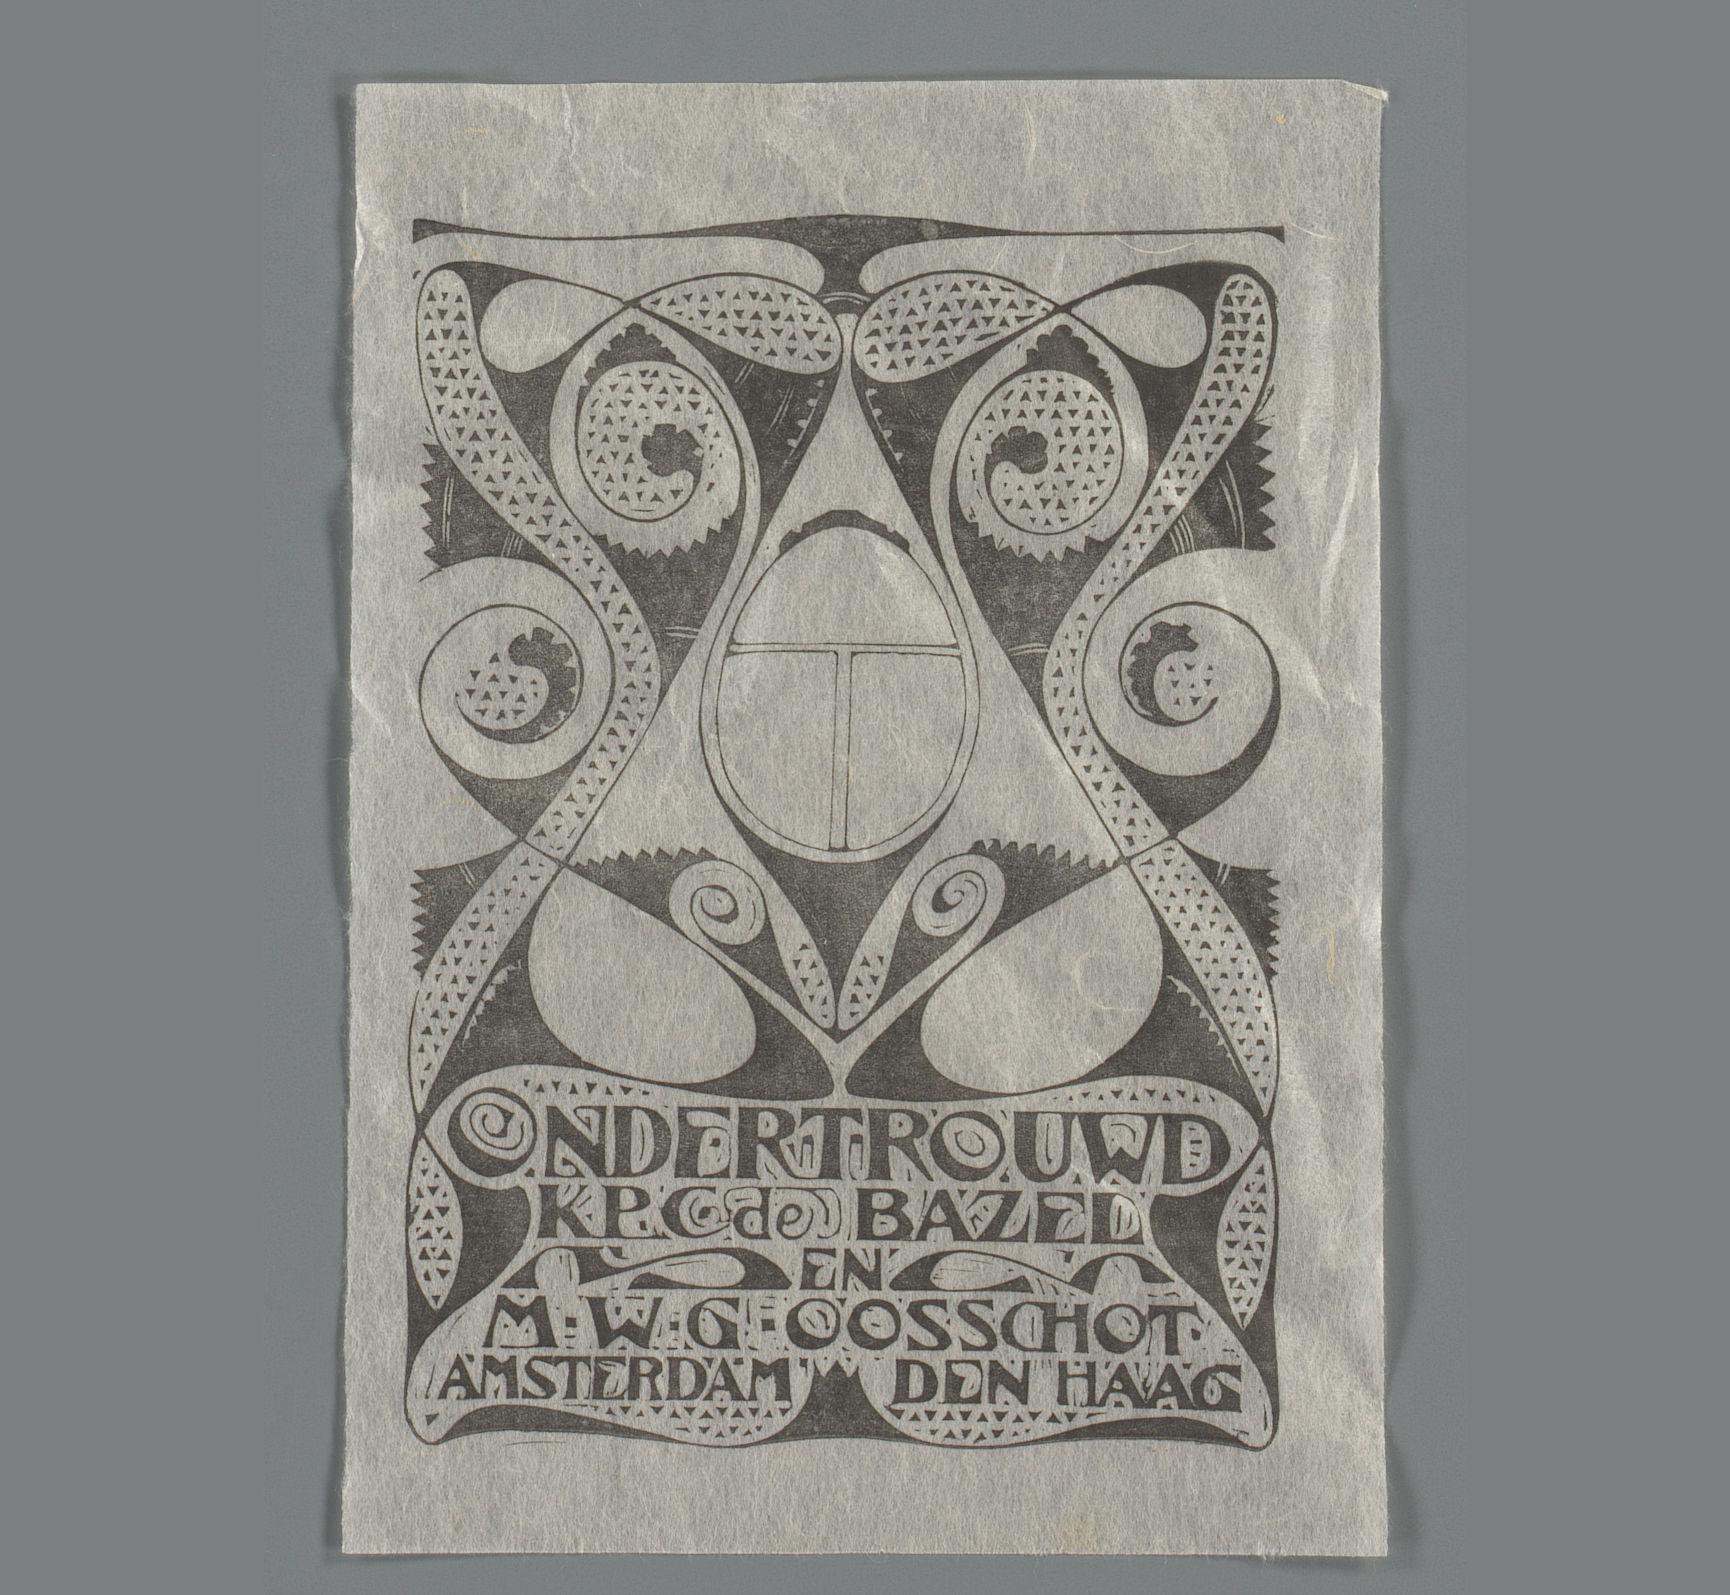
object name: wedding announcement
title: Ondertrouwaankondiging van Karel de Bazel en M.W.G. van Oosschot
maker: karel petrus cornelis de bazel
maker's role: draughtsman, print maker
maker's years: 1869-1923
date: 1895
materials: paper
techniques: woodcut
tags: den helder, amsterdam, print maker, draughtsman, karel petrus cornelis de bazel, betrothal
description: Decoratief kader rond de tekst: 'Ondertrouwd K.P.D. de Bazel en M.W.G. Oosschot, Amsterdam - Den Haag'.